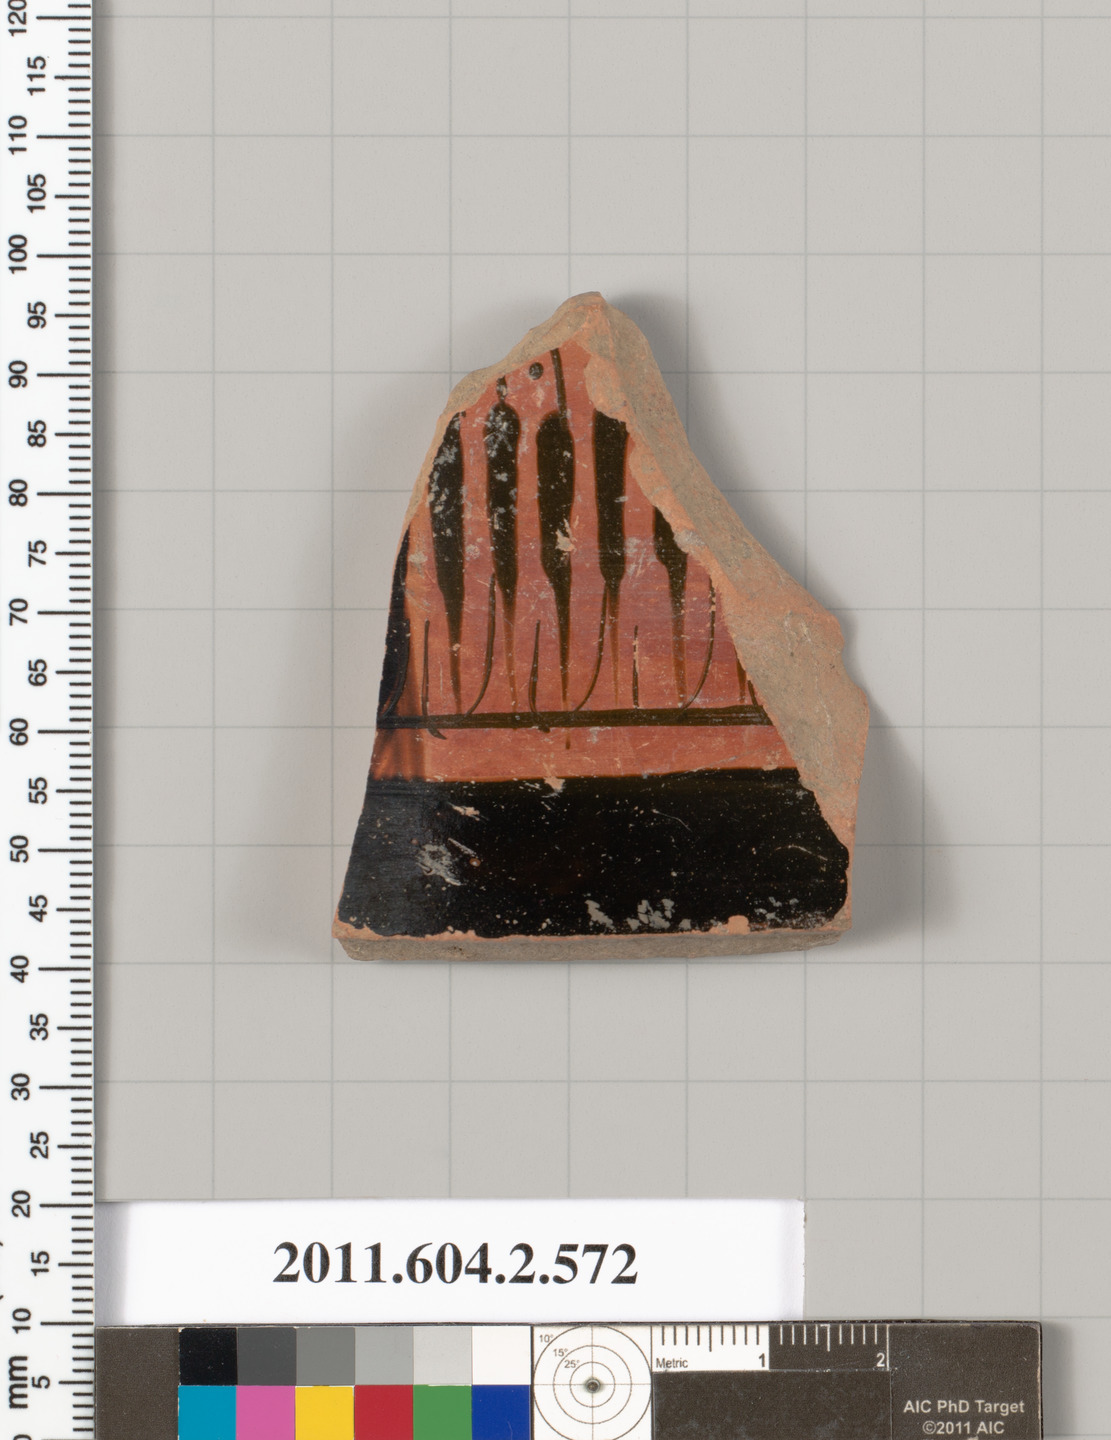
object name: column krater fragment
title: Terracotta fragment of a column-krater (bowl for mixing wine and water)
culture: greek, attic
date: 460-440 BCE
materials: terracotta